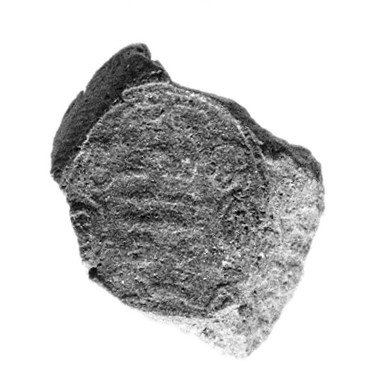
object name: sealing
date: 1981-1640 BCE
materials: mud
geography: egypt